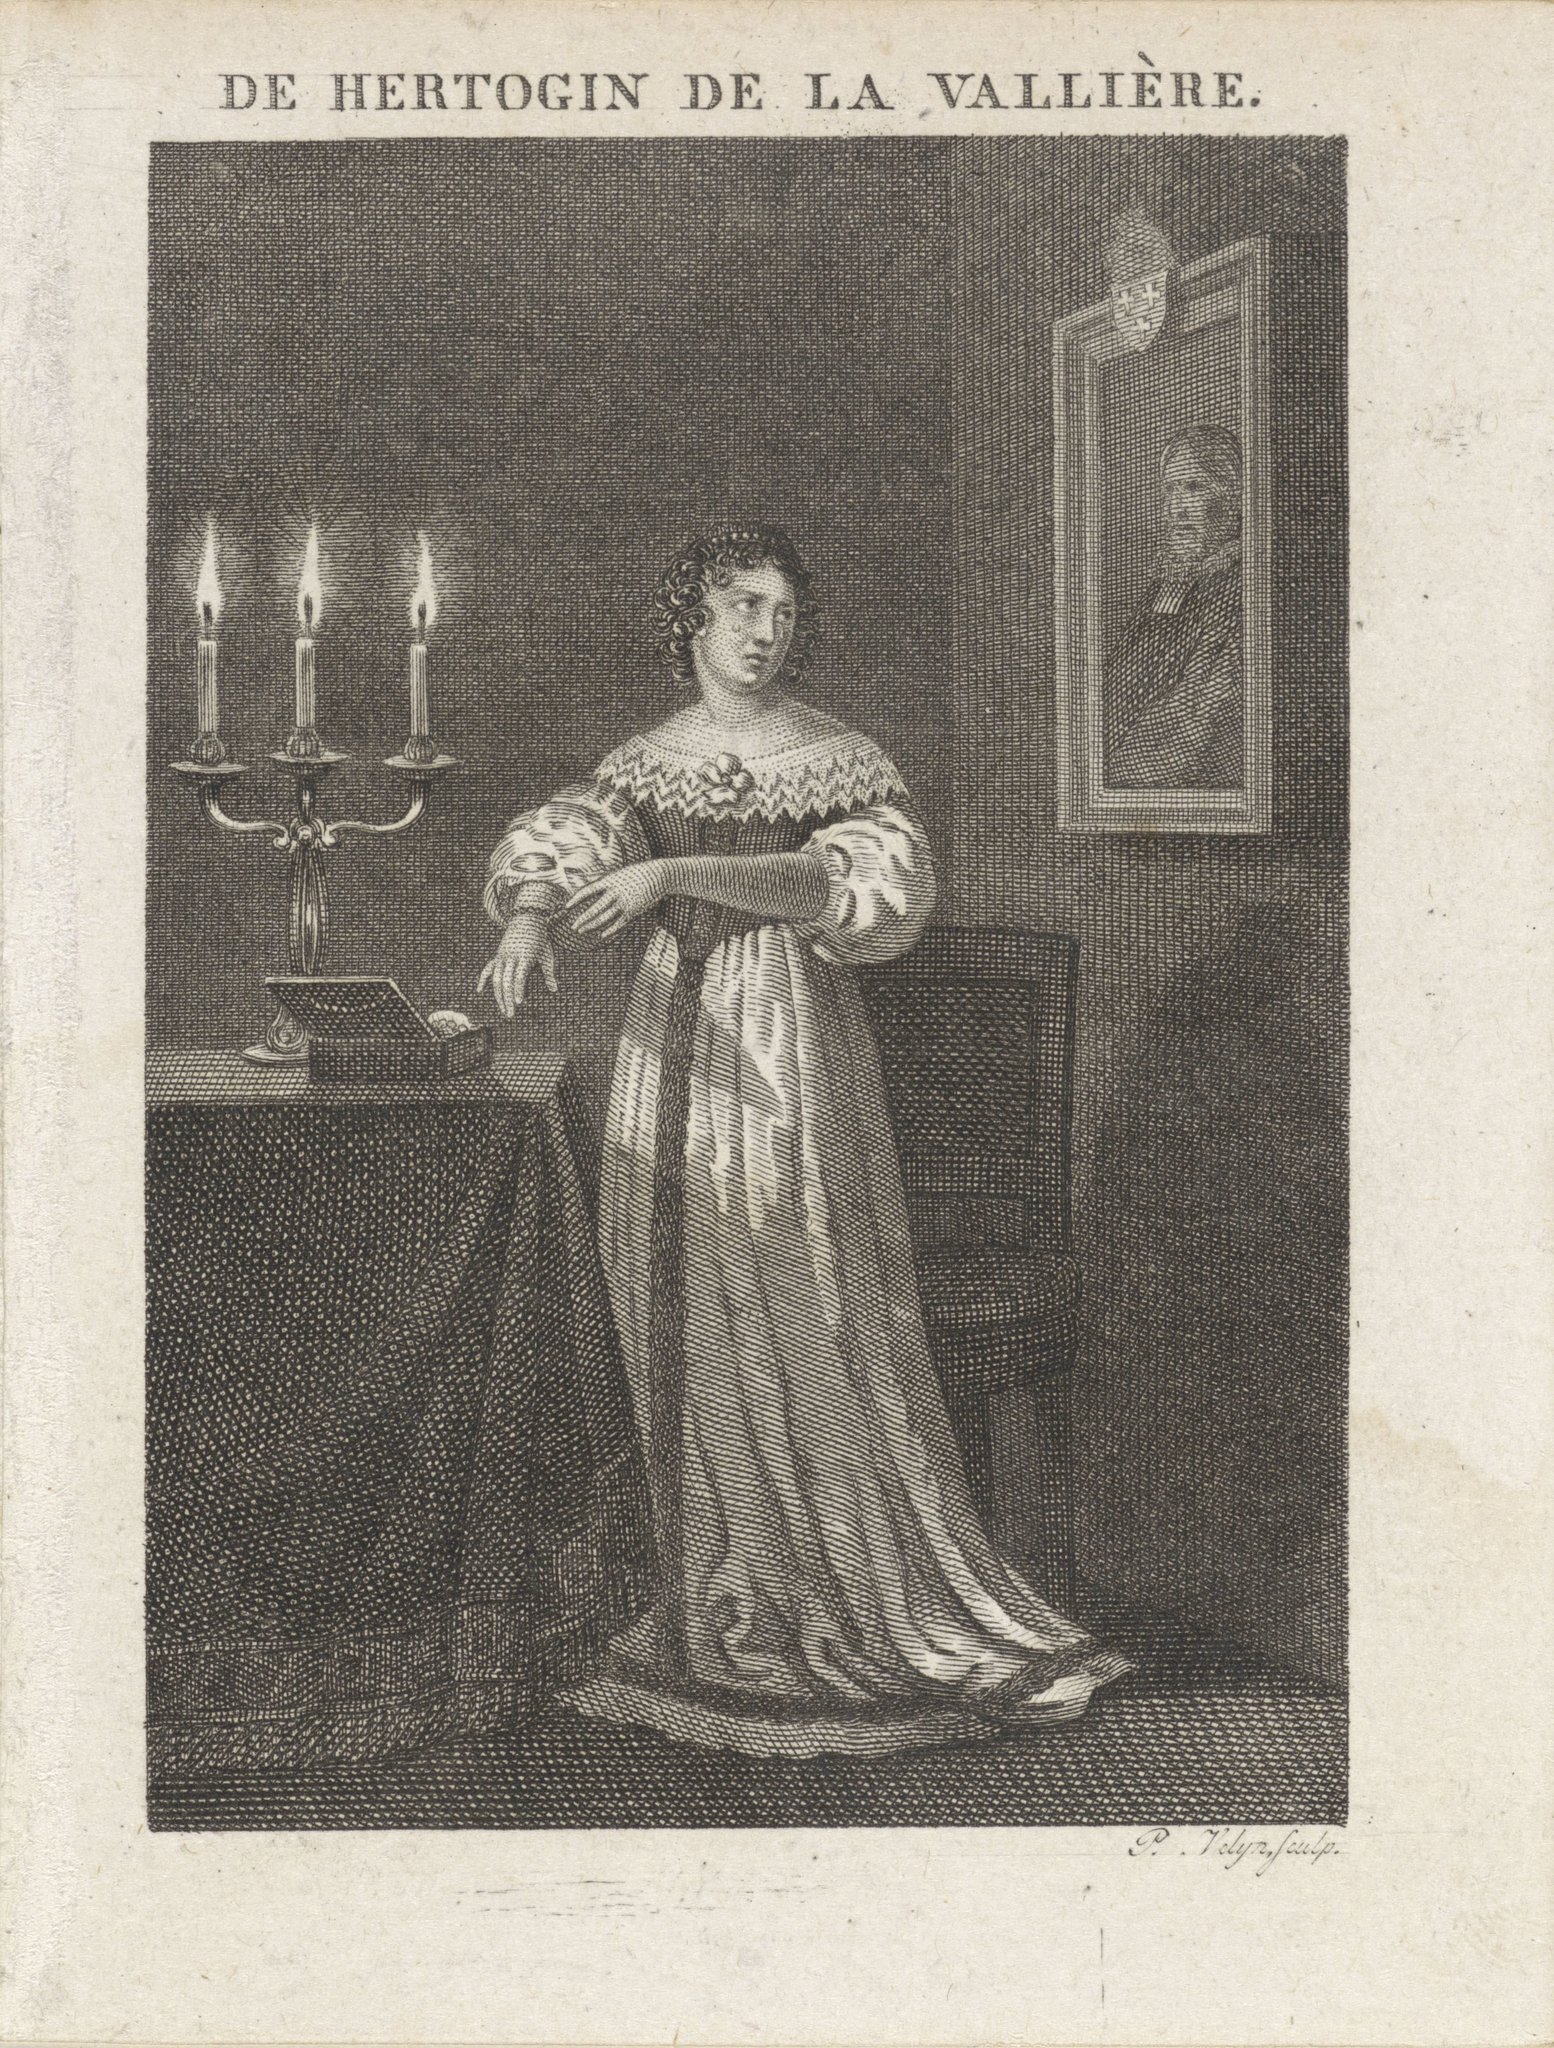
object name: print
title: Dame bij een tafel met een kistje en een kandelaar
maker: philippus velijn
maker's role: print maker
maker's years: 1787-1836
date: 1822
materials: paper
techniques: engraving, etching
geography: netherlands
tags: jewel-box (+ variant), candle, picture, painting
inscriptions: collector's mark: Lugt 2228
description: Een dame staat bij een tafel waarop een kistje en een kandelaar met drie brandende kaarsen. Zij kijkt naar een mansportret aan de wand achter haar.